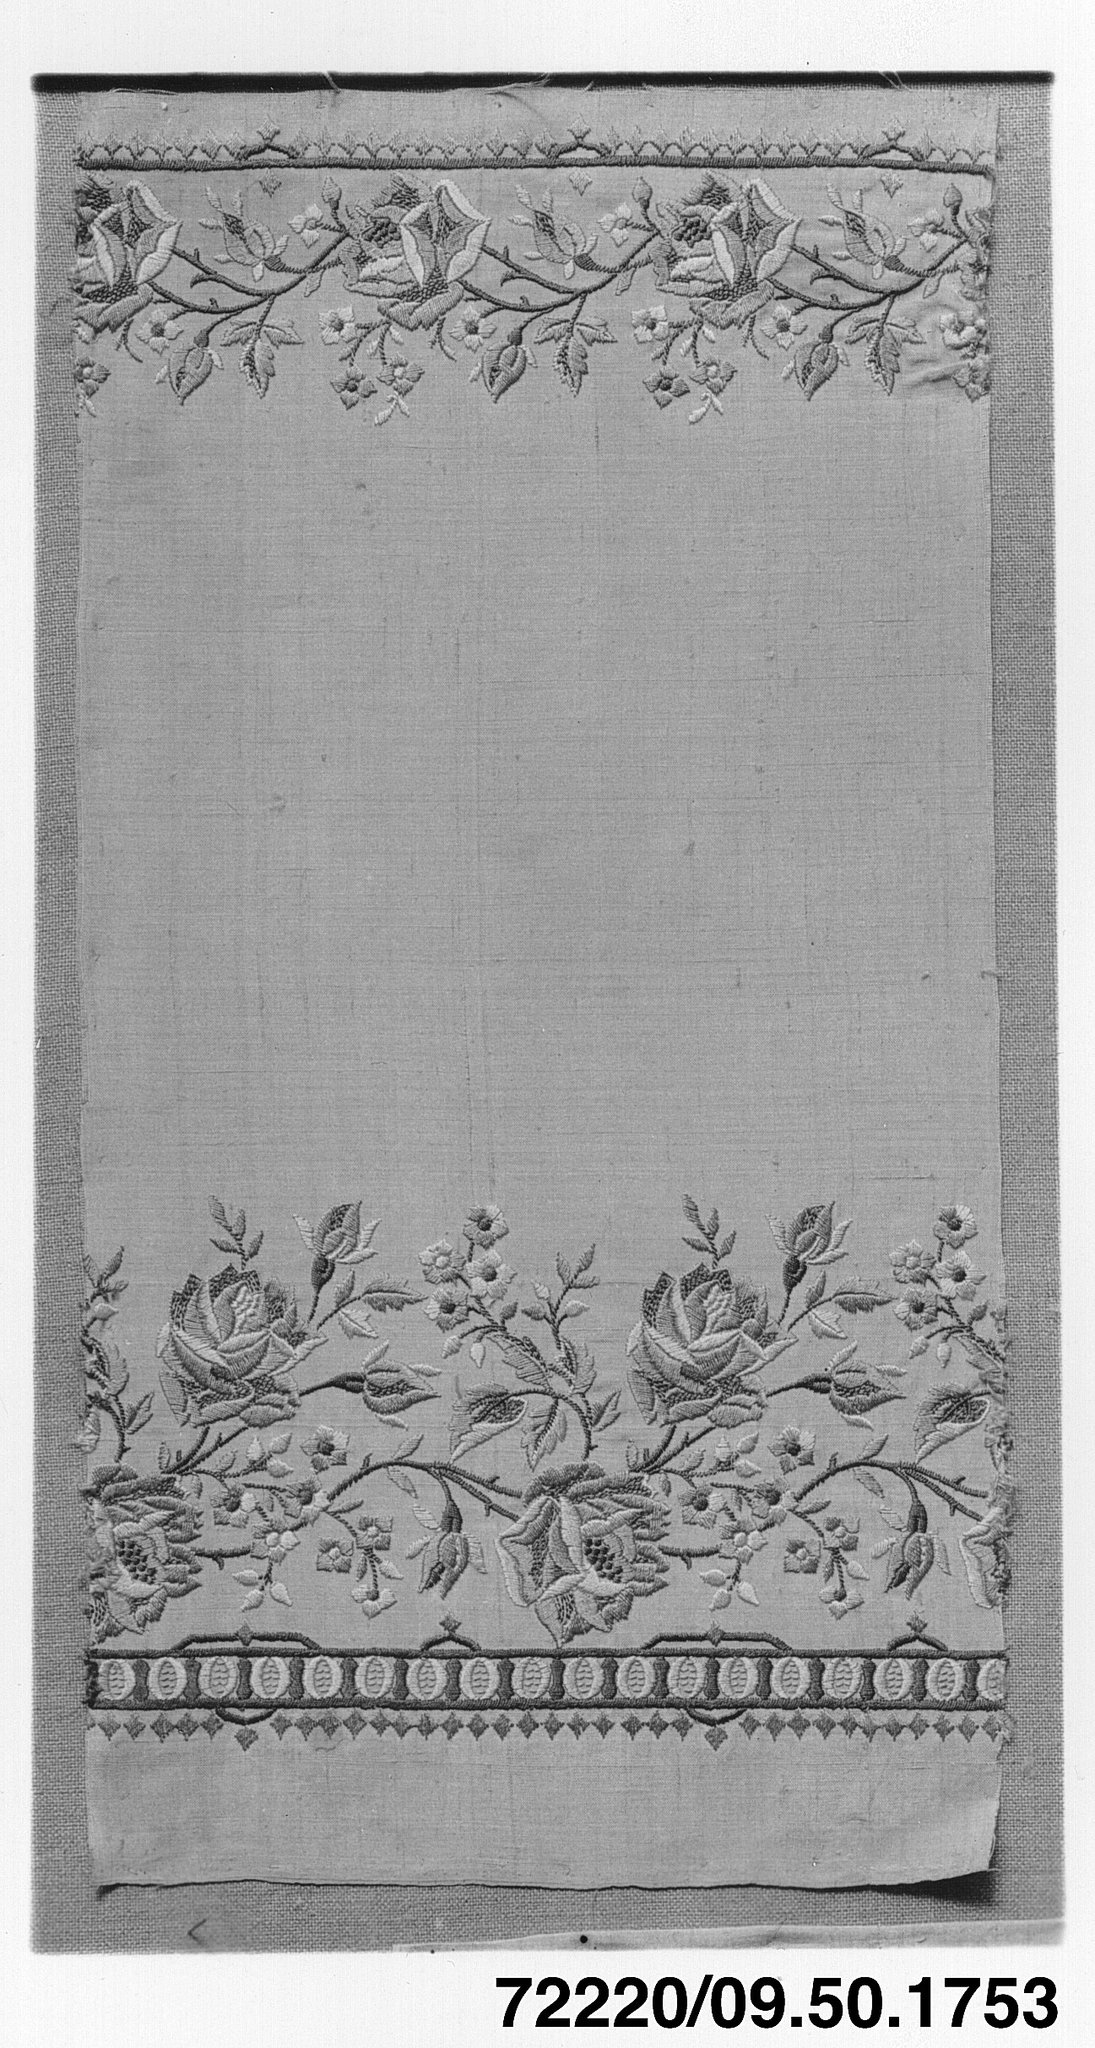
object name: fragment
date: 1801-1900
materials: silk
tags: flowers,leaves